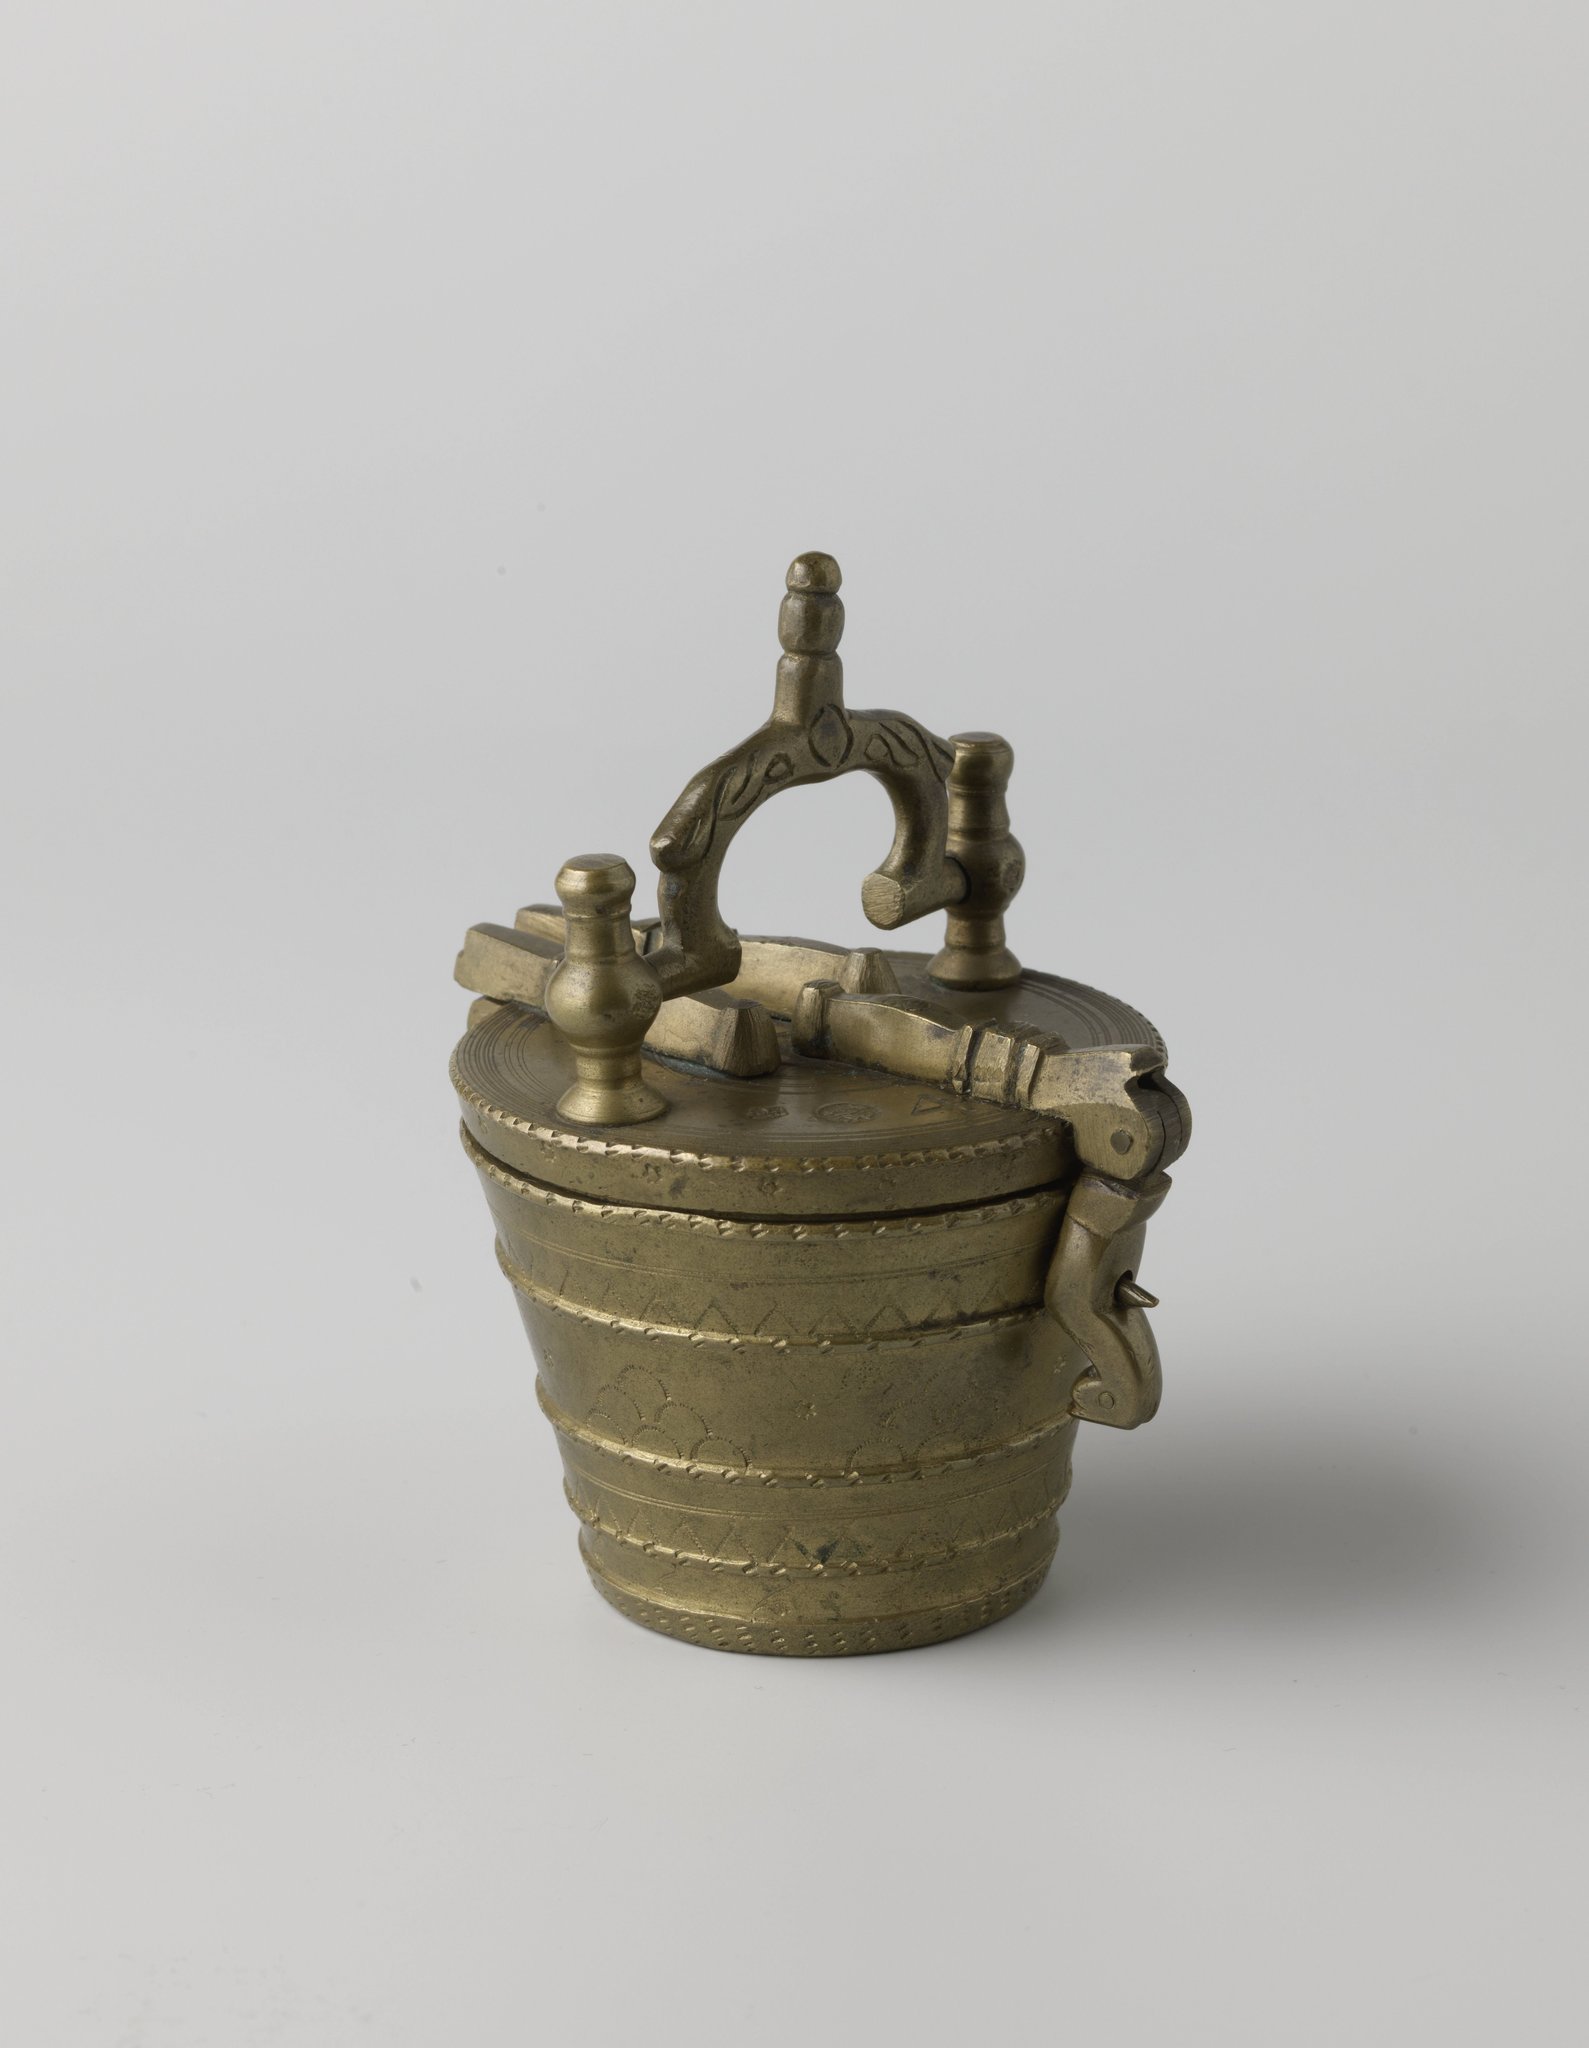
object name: sluitgewicht, pijlgewicht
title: Sluitgewicht van 4 Hollands Troois pond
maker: christoph jobst rothenberger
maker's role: instrument maker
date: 1800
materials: brass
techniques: casting, punching, riveted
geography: nuremberg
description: Het voorwerp bestaat uit zeventien delen: de tien gewichten, de bak en het deksel (die het huis vormen), een scharnier, een sluitbeugel, twee hengselaanzetten, het hengsel. Bij de bak, het deksel en de gewichten is het centerpunt te zien. Bak en deksel hebben smalle geponst-bewerkte ribben. De tussenliggende vlakken hebben o.a. gegroefde ringen, geponste driehoeken en een uit geponste boogjes opgebouwde versiering. Scharnier, sluitbeugel en hengselaanzetten zijn geklonken. In het hengsel, dat bovenaan van een knop is voorzien, zijn twee drakenkoppen te herkennen. Op het deksel zijn de volgende tekens ingeslagen: een Franse lelie, een statenleeuw met de letters SGN, het getal 4, een haan en de ijkletter T. In de bodem van de bak het getal 2, een Franse lelie, een statenleeuw met onleesbare letters, de ijkletters B (drukletter) YV (schrijfletters). Aan de onderkant de ijkletters TAN en de ijkletters G en K (drukletters). In de bodem van het eerste gewicht - het pond - een statenleeuw (vaag te herkennen) en de ijkletters B (drukletter) YV (schrijfletters). Aan de onderkant de ijkletters G en K (drukletters). In de bodem van het tweede gewicht het getal 16 (lood), de Franse lelie, de statenleeuw met SGN en de ijkletters B (drukletter) en YVT (schrijfletters). Op het derde gewicht in de bodem het getal 8 (lood), een Franse lelie, de statenleeuw met SGN, en de letters YVT (schrijfletters), aan de onderkant de ijkletters GK (drukletters). Op het vierde gewicht in de bodem het getal 4, een Franse lelie, een statenleeuw met SGN, de ijkletters B (drukletter) en YVT (schrijfletters), aan de onderkant de ijkletters GK (drukletters). Op het vijfde gewicht het getal 2 en dezelfde merken en letters als op het voorgaande gewicht. Zo ook op het zesde gewicht. De laatste vier gewichten zijn slechts gemerkt met de Franse lelie. Alle gewichten zijn met lood gejusteerd (d.w.z. op het juiste gewicht gebracht).